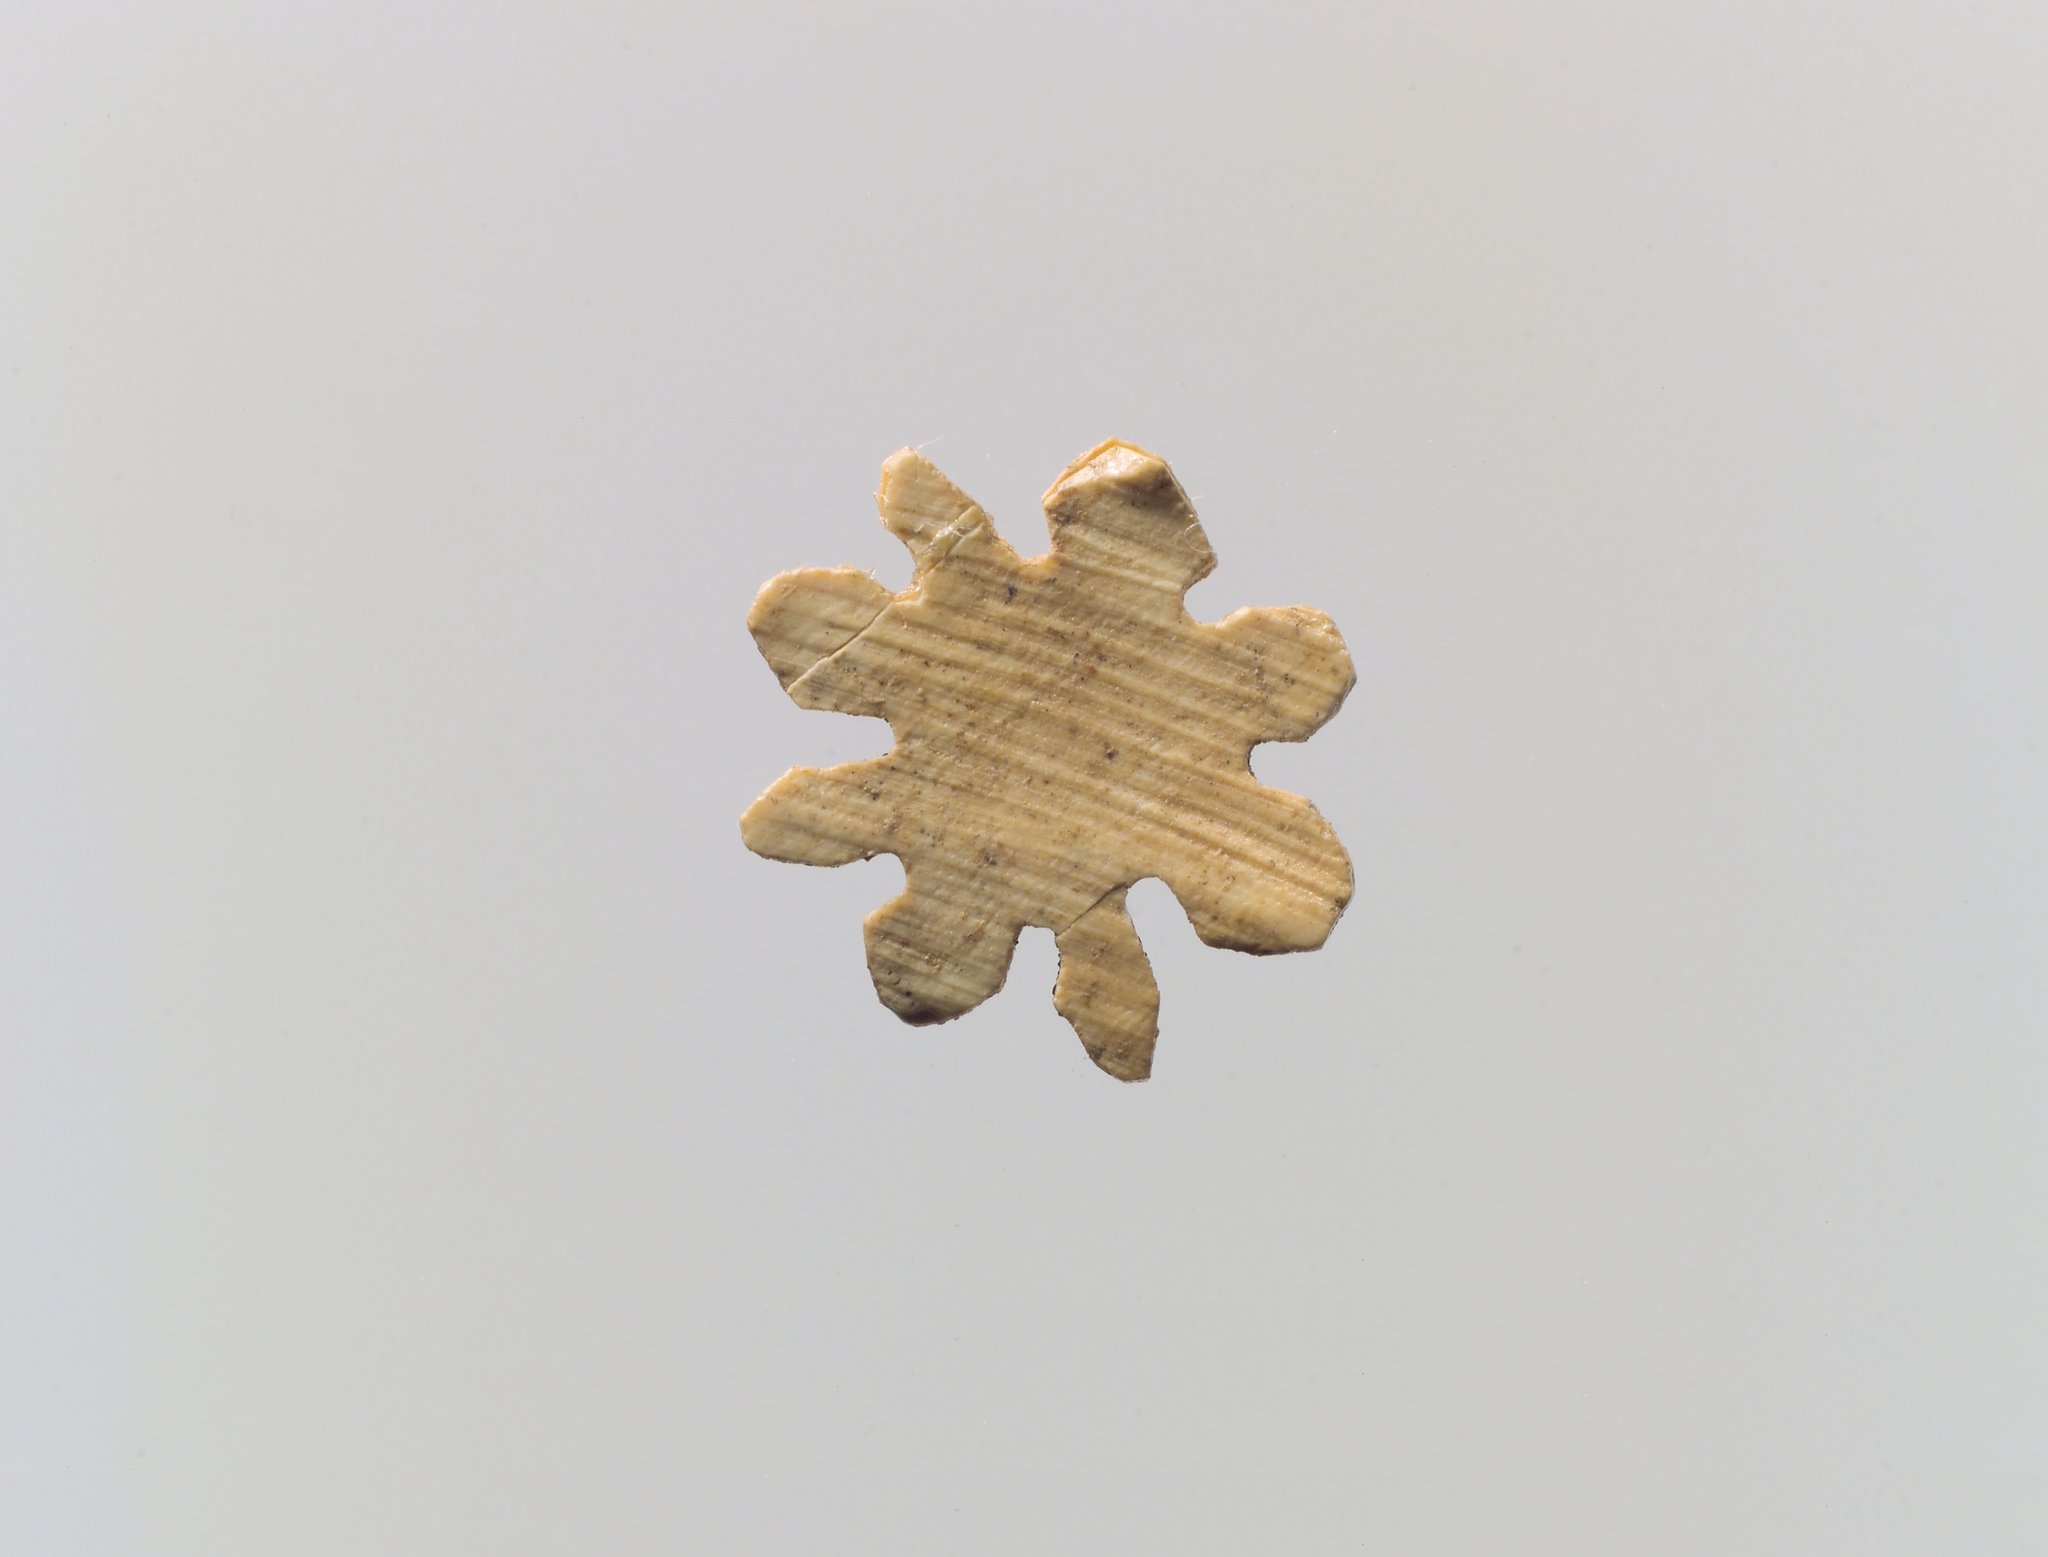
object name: inlay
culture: iranian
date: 800-601 BCE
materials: ivory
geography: iran